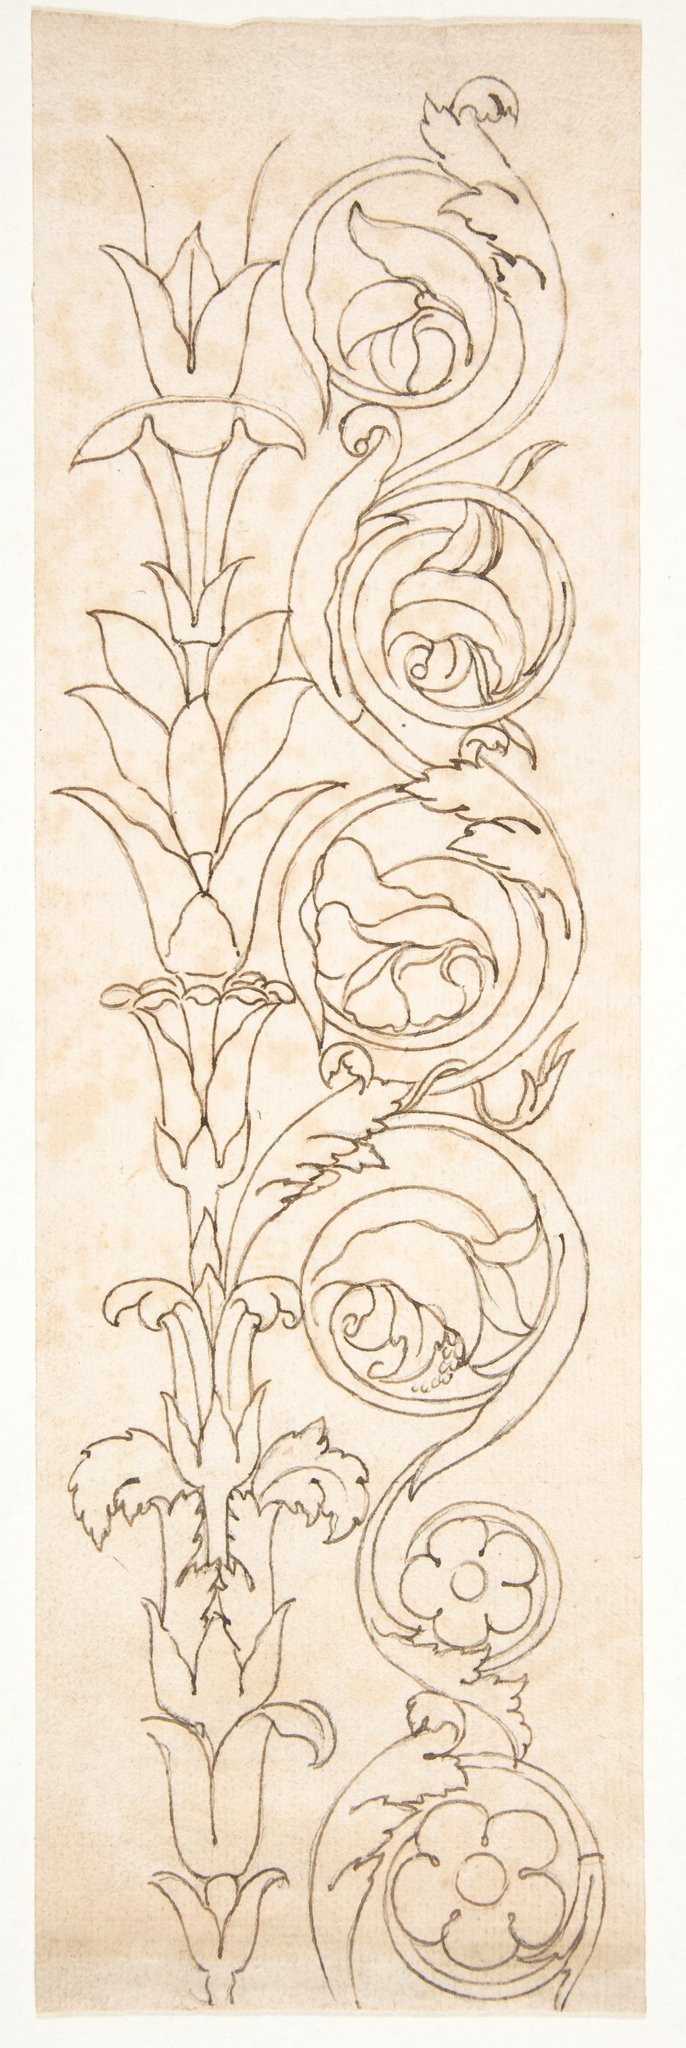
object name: collection ornament architecture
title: Ornamental drawings (recto) blank (verso)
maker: anonymous, french, 16th century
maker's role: draftsman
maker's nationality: french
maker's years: 1500-1600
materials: chalk, ink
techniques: incising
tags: flowers